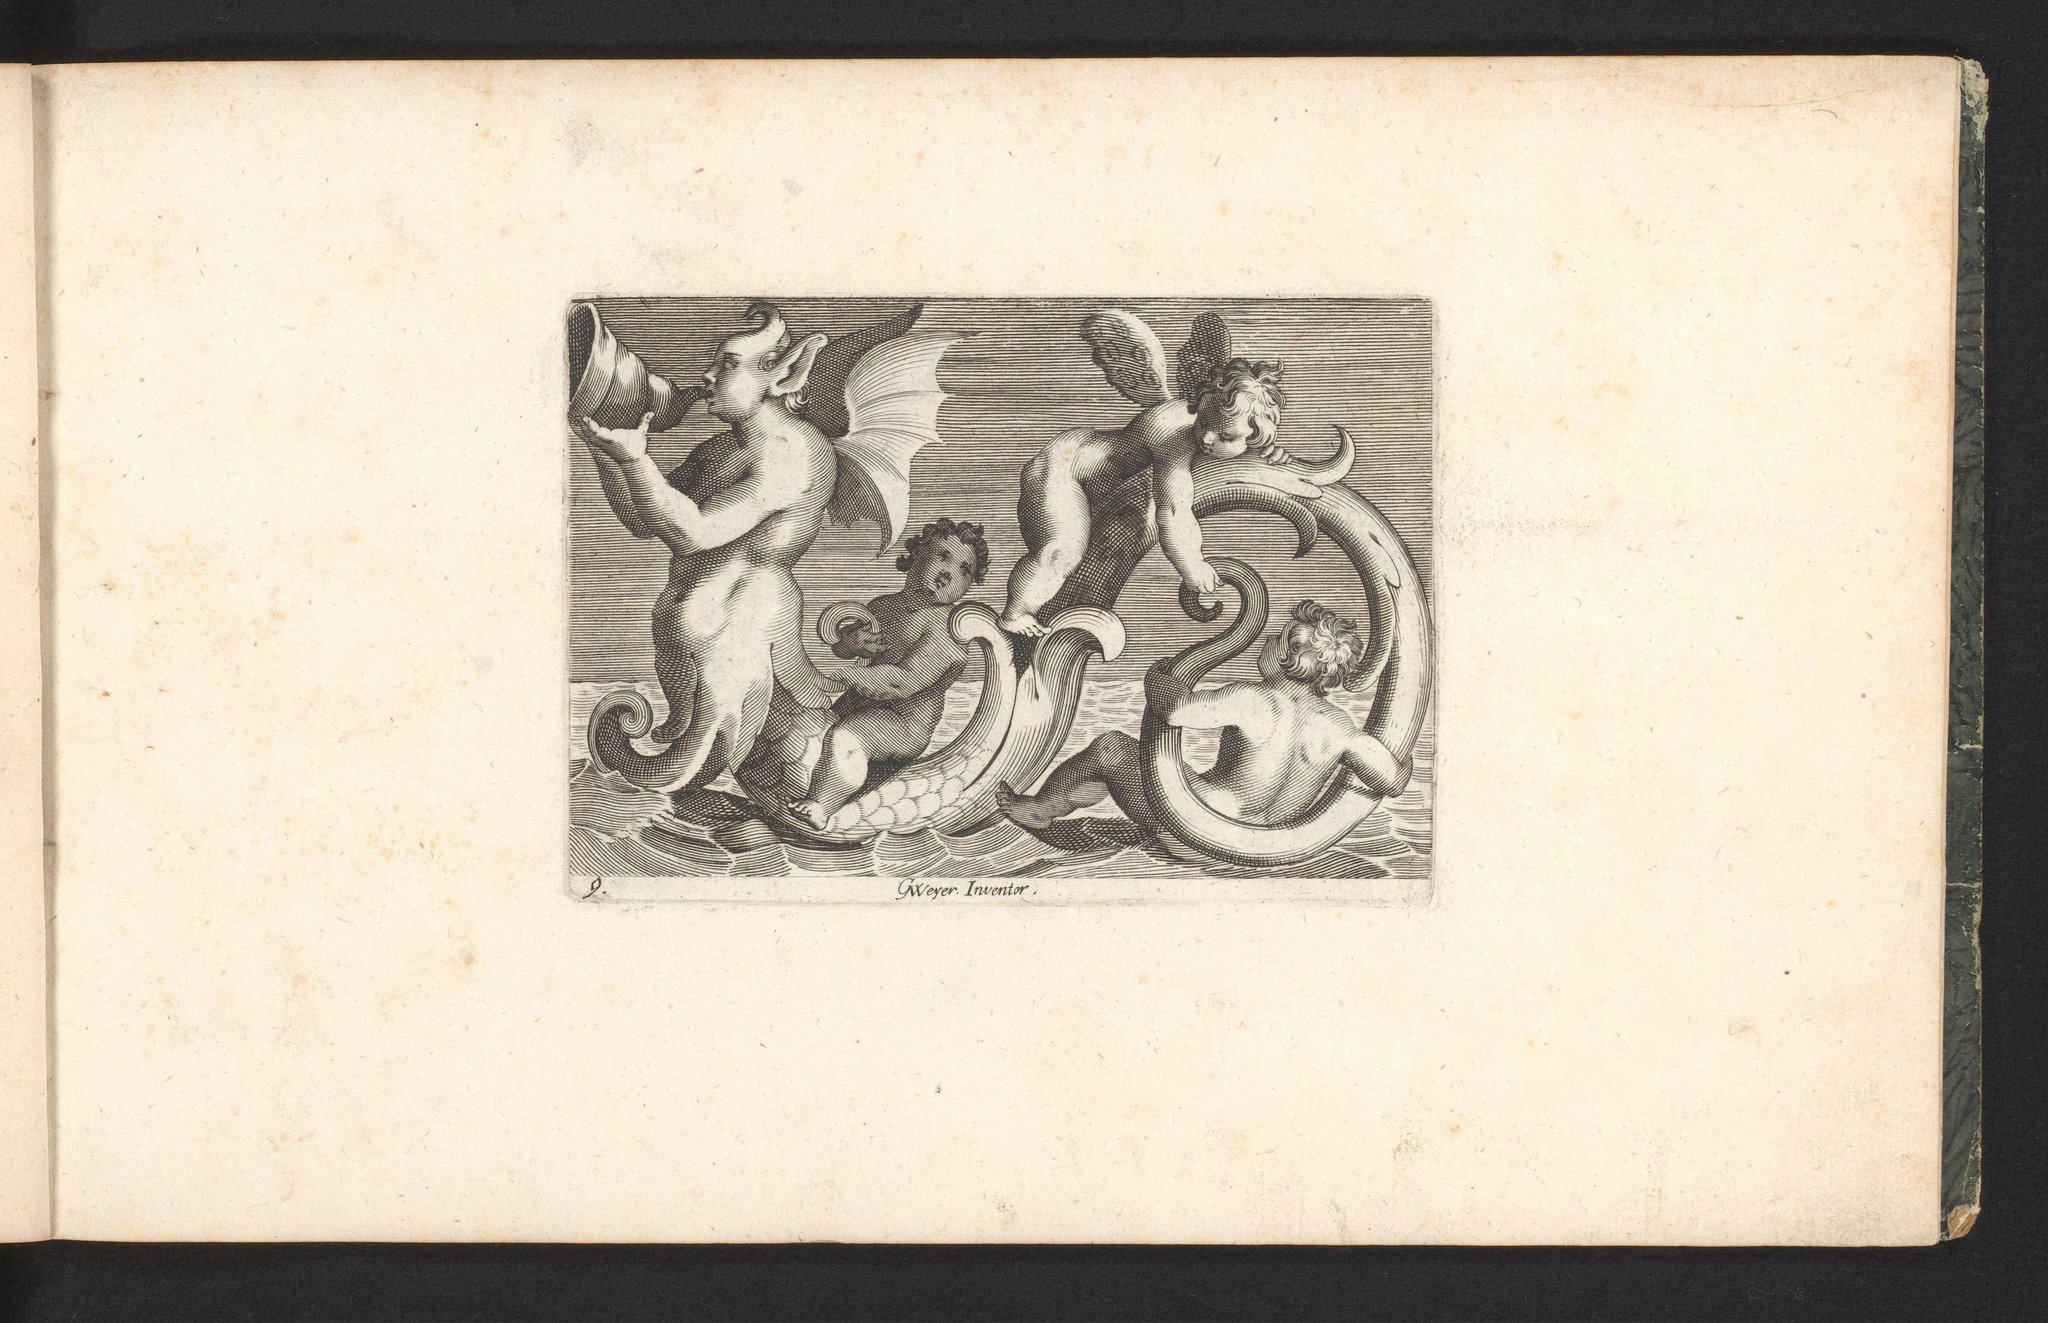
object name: ornament print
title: Zeemonsters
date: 1571-1635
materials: paper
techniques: engraving, etching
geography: nuremberg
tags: monsters of the sea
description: Een op een schelp blazend zeewezen met vissenstaart en op de rug drie putti.